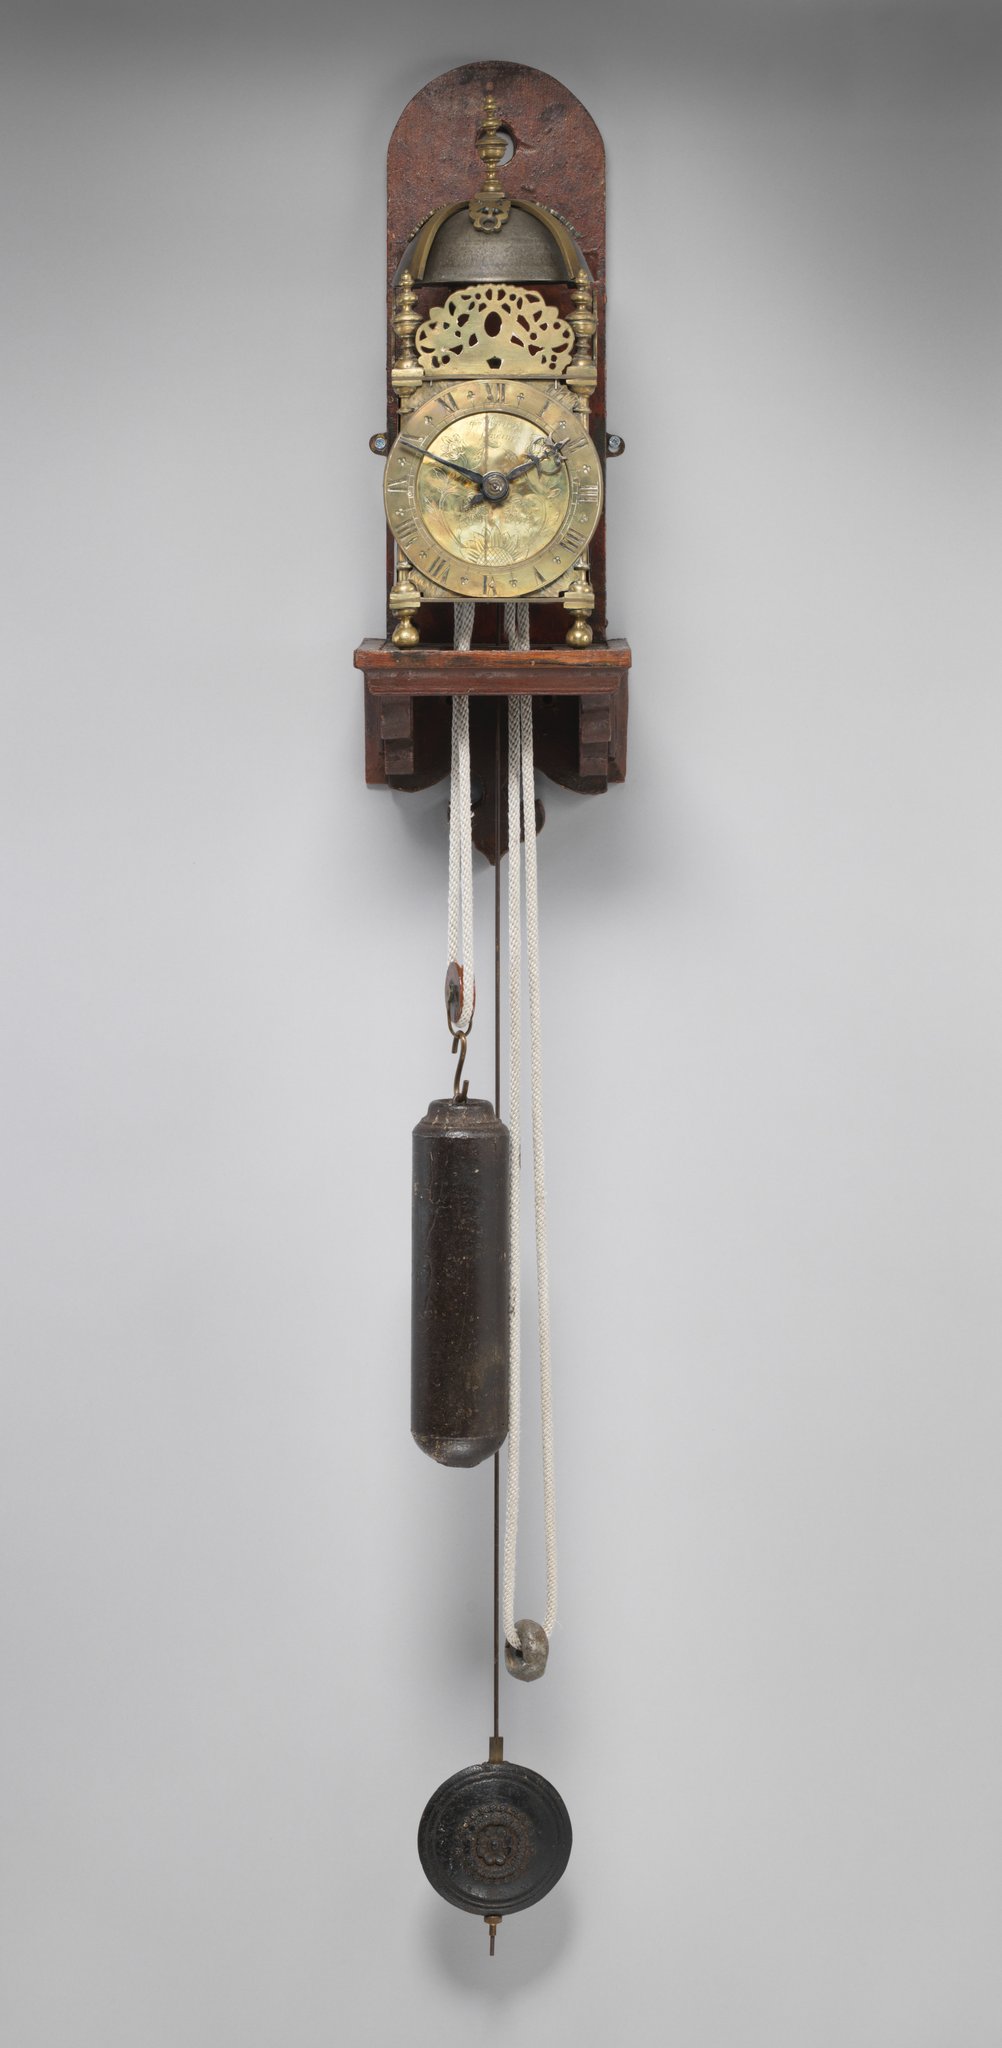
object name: lantern clock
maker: joseph knibb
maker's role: maker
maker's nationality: british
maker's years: 1640-1711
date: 1675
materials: brass